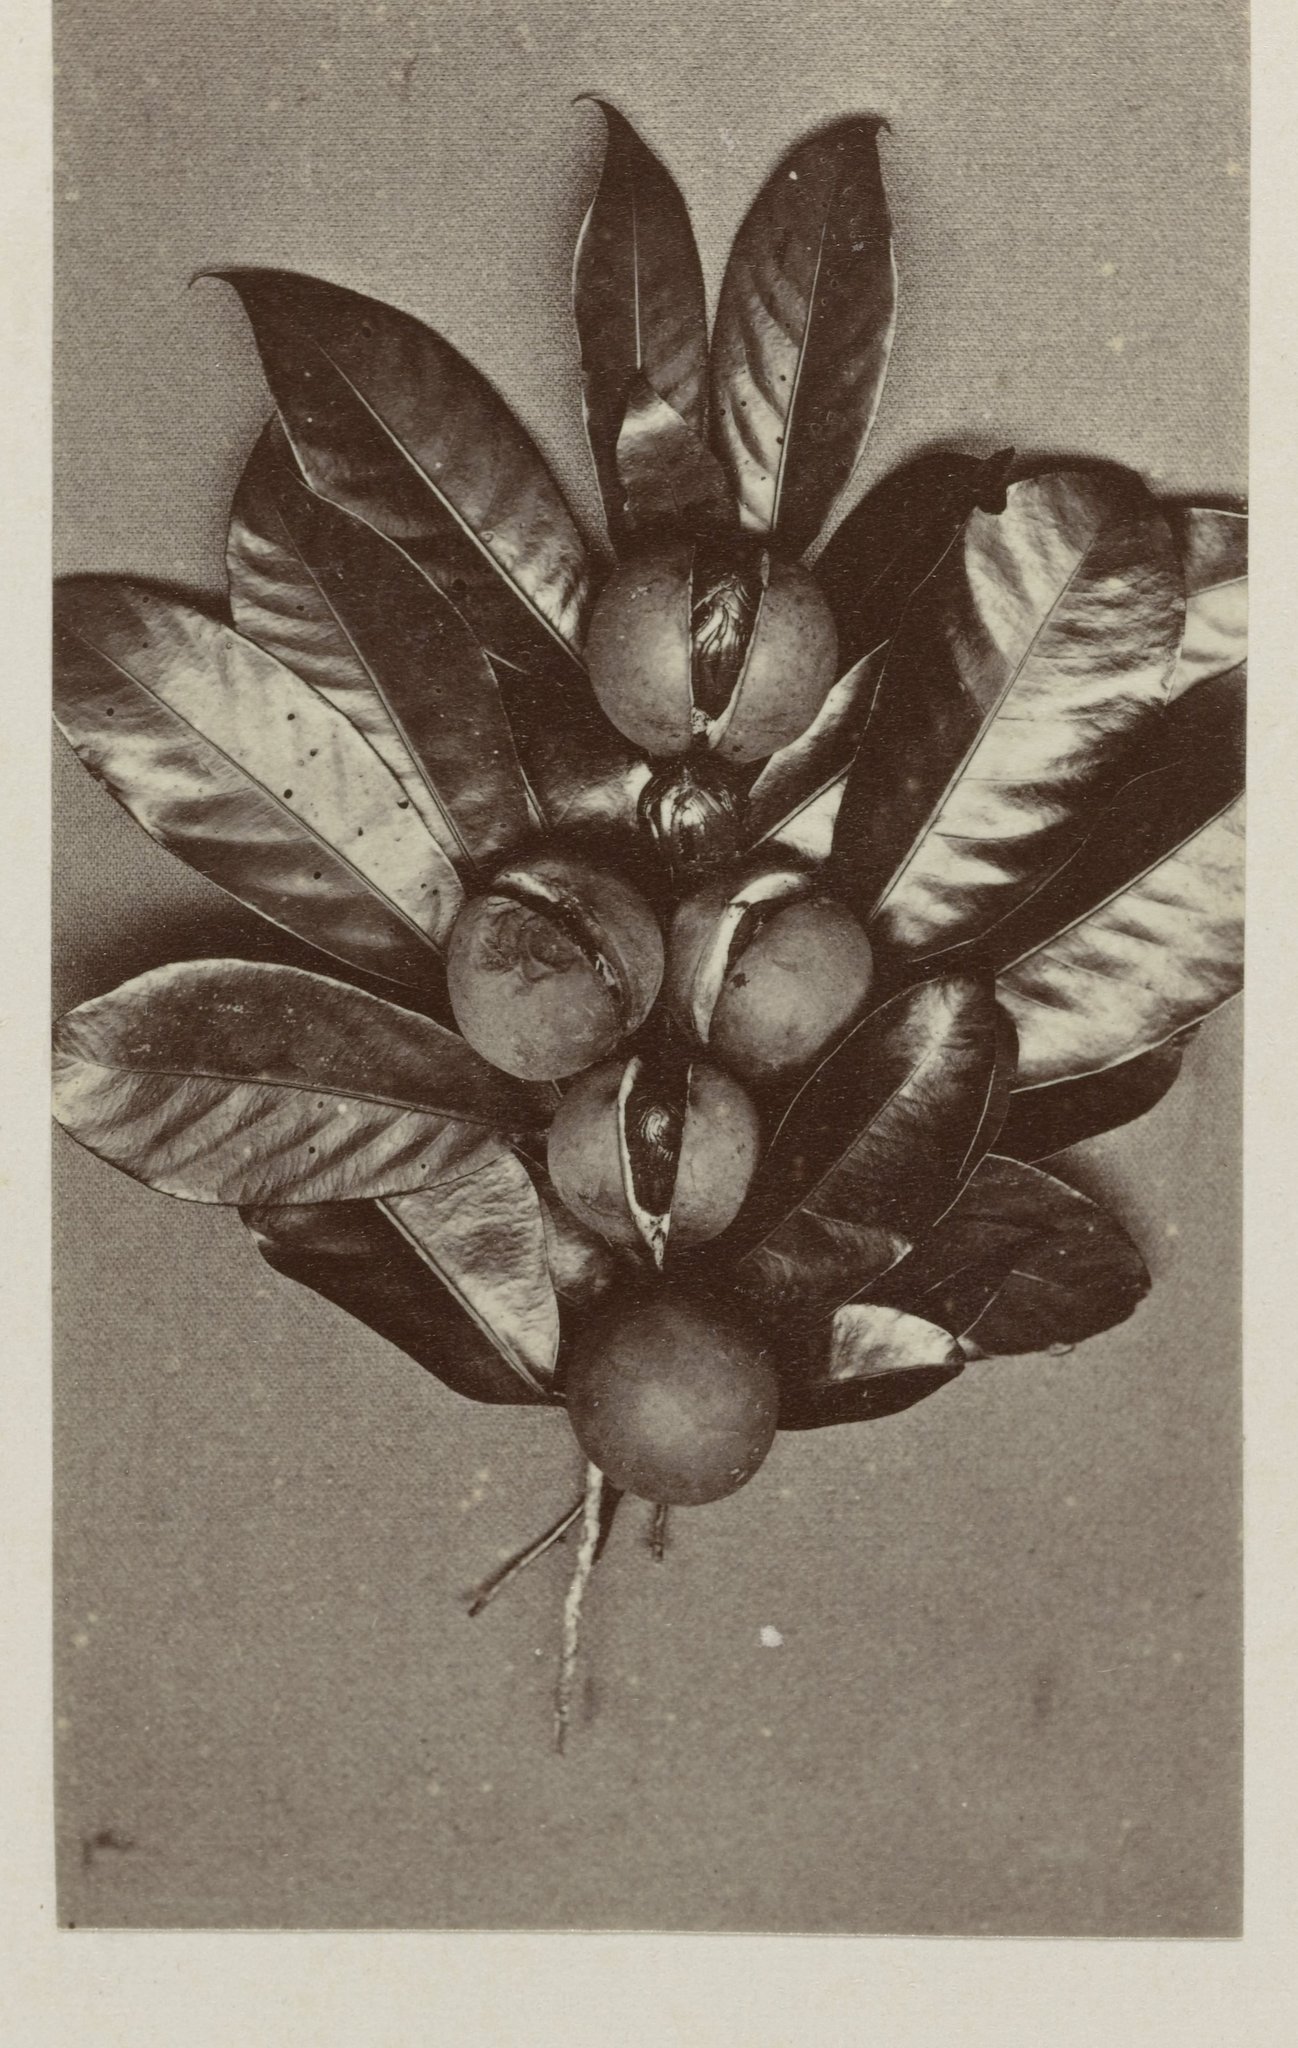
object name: photograph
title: Nootmuskaat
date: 1870-1880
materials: photographic support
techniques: albumen print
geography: batavia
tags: seasonings, spices (with name), java, batavia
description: Enkele takken nootmuskaat met opengebarsten vruchten. Ingeplakte foto in het fotoalbum getiteld: Gezichten van Java.